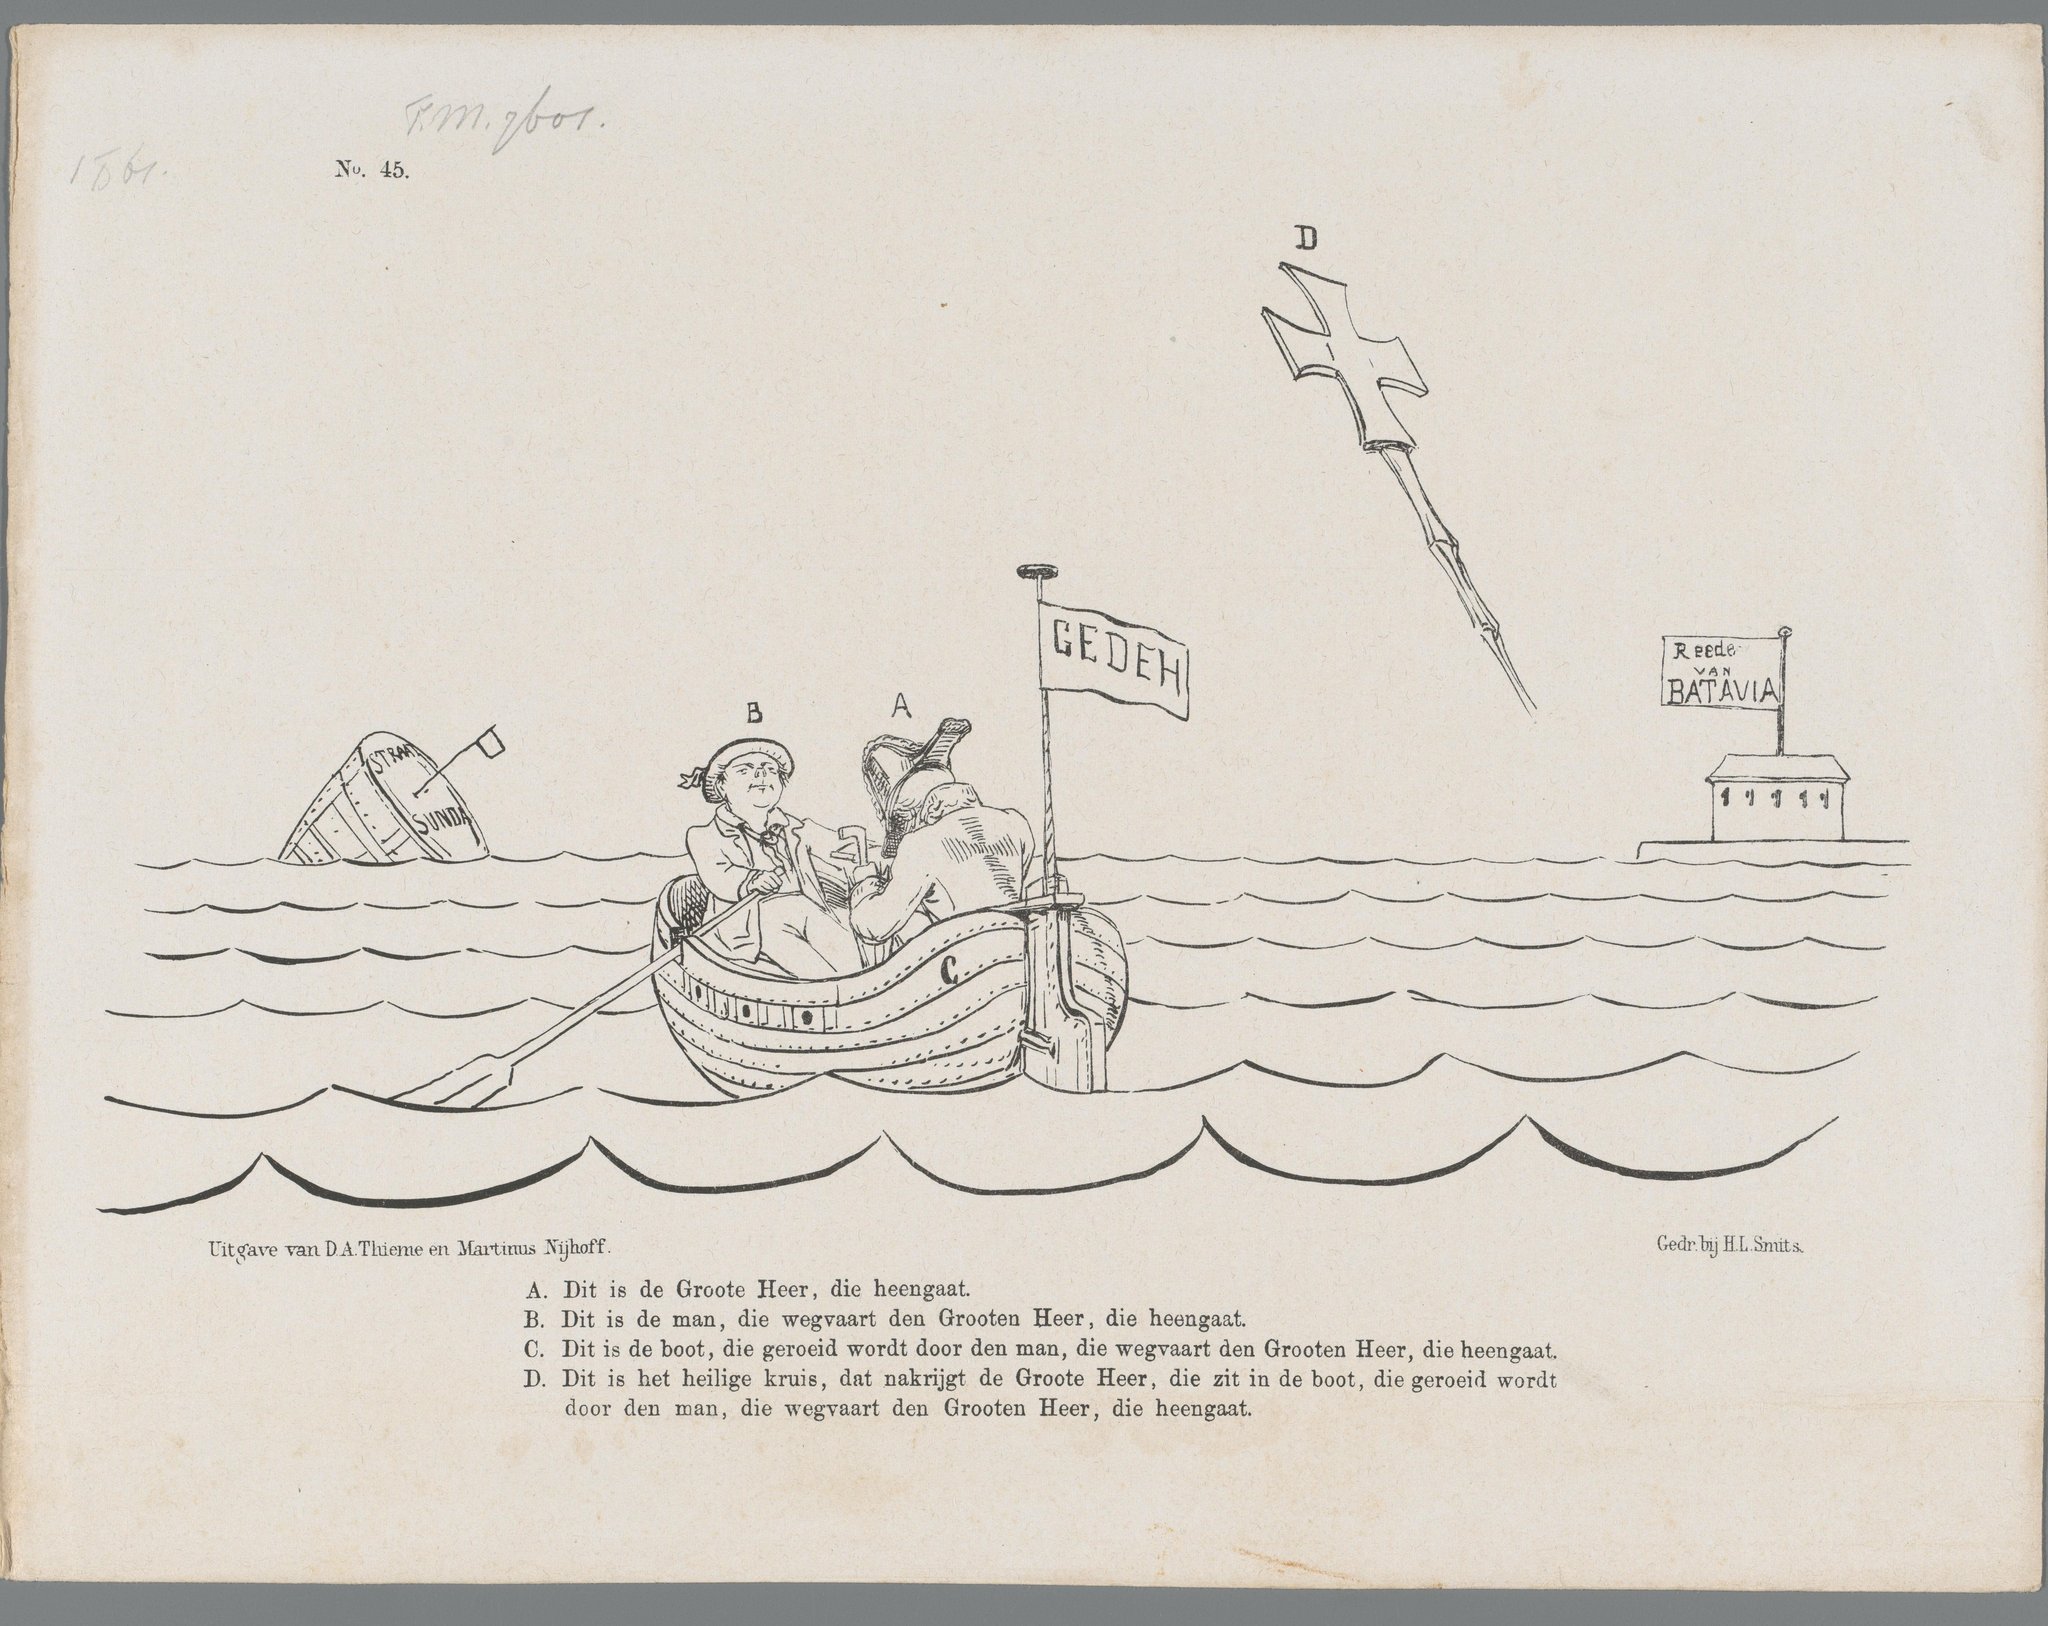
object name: print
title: Spotprent op het ontslag van gouverneur-generaal Mortanges, 1861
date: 1861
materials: paper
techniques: lithograph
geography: netherlands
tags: dutch east indies, the, batavia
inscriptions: collector's mark: Lugt 2228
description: Spotprent op de het ontslag van gouverneur-generaal Charles Ferdinand Pahud de Mortanges op 2 september 1861. Mortanges in een sloep geroeid door een matroos, rechts de rede van Batavia, links het zinkende schip 'Straat van Sunda'. Plaat verschenen bij het weekblad De Nederlandsche Spectator, nr. 45, 9 november 1861.